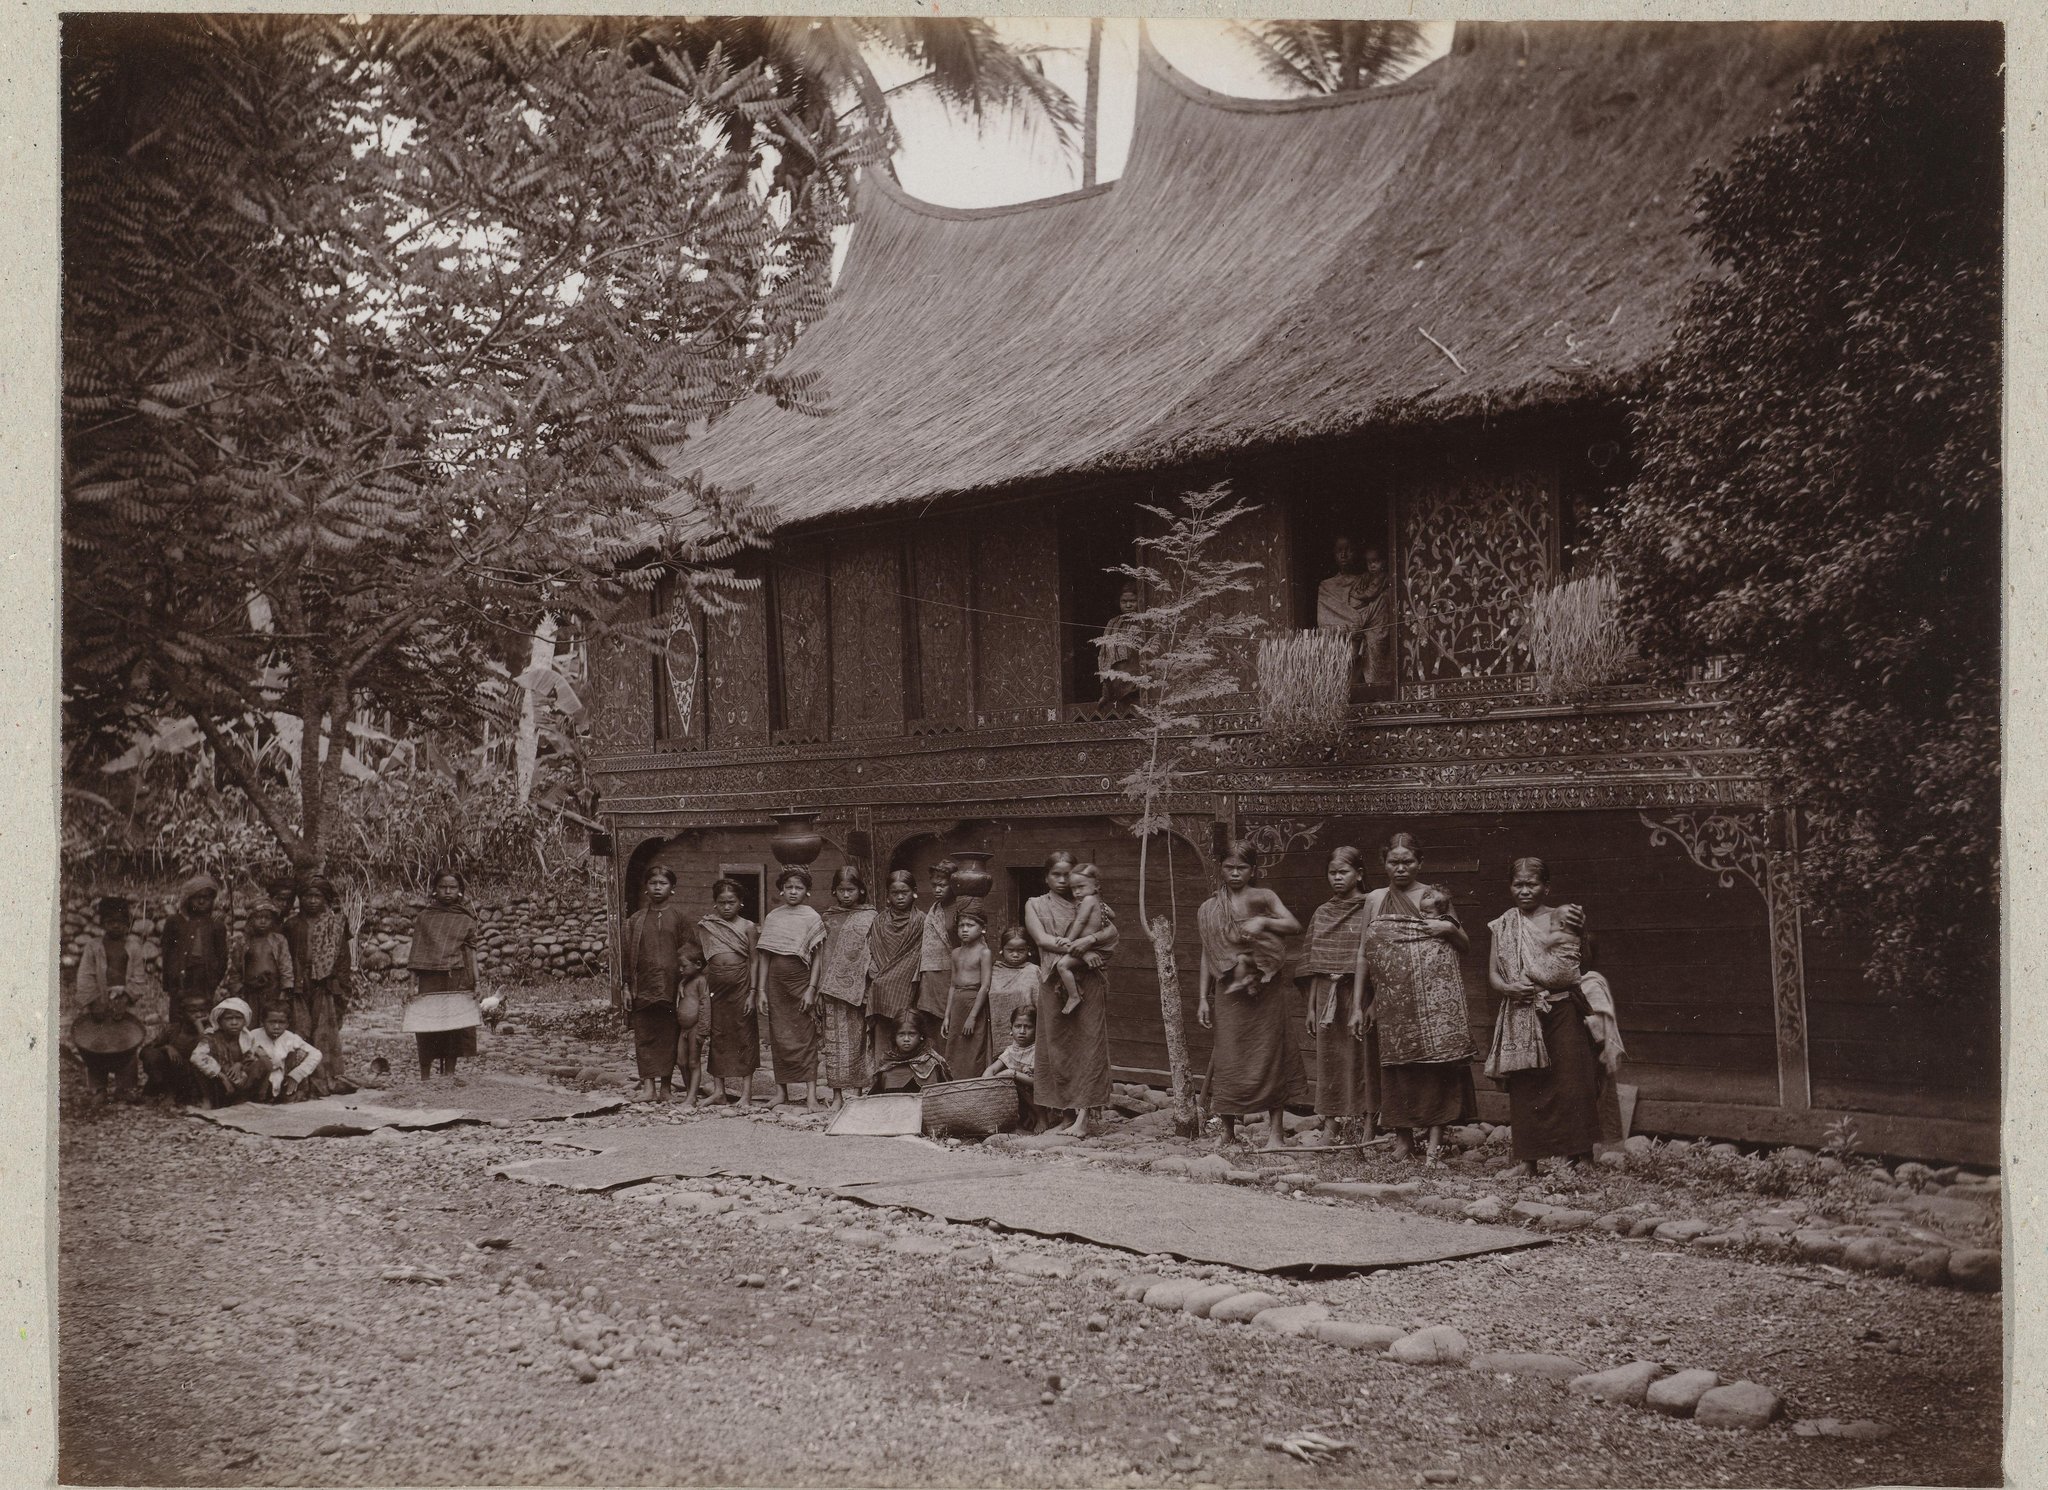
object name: photograph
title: Een Minangkabau gemeenschapshuis met daarvoor een aantal vrouwen en kinderen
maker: christiaan benjamin nieuwenhuis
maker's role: publisher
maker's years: 1863-1922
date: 1891-1912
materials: paper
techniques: albumen print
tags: exterior ~ representation of a building, anonymous historical persons portrayed in a group, in a group-portrait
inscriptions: inscription: ‘Kampong Kanoni [...]’